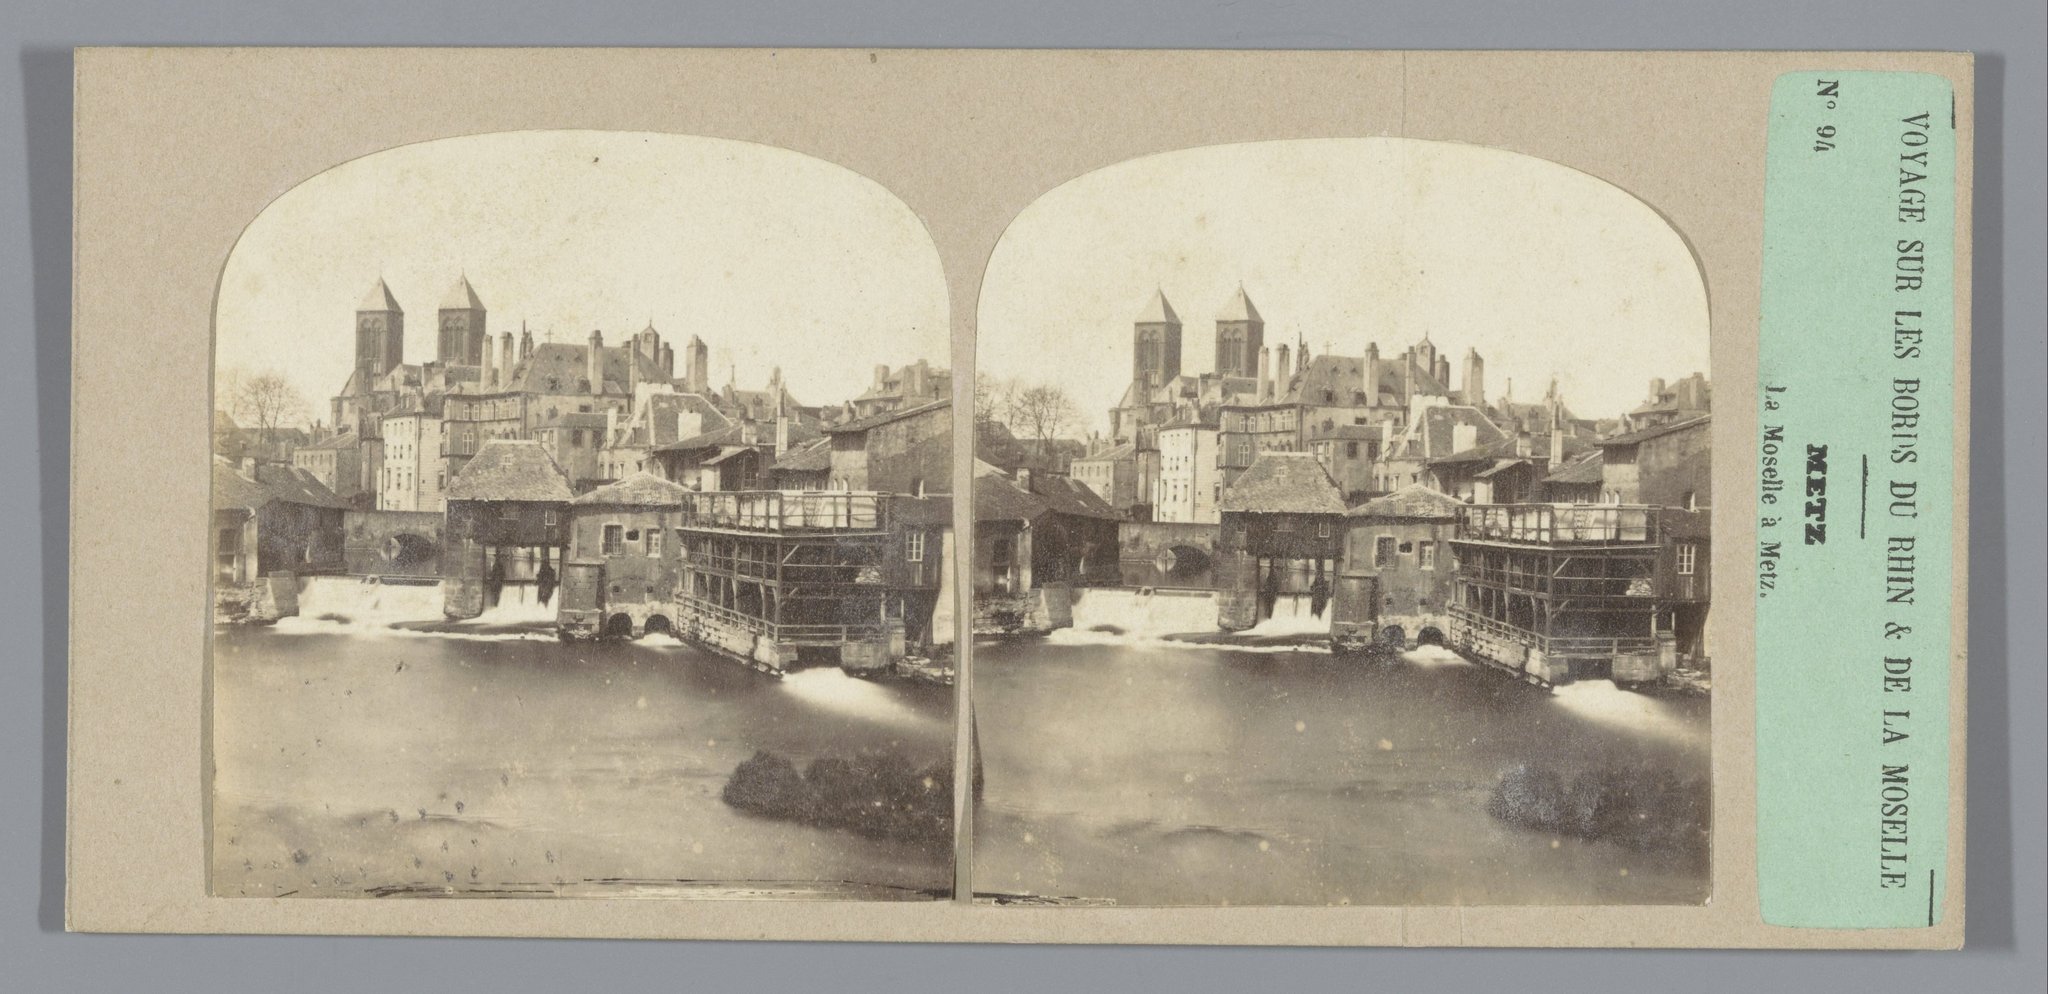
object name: stereograph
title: Metz, La Moselle à Metz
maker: Anonymous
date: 1860-1865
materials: cardboard, photographic support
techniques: albumen print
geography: metz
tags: city-view, and landscape with man-made constructions, river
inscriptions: number: ‘No 94’